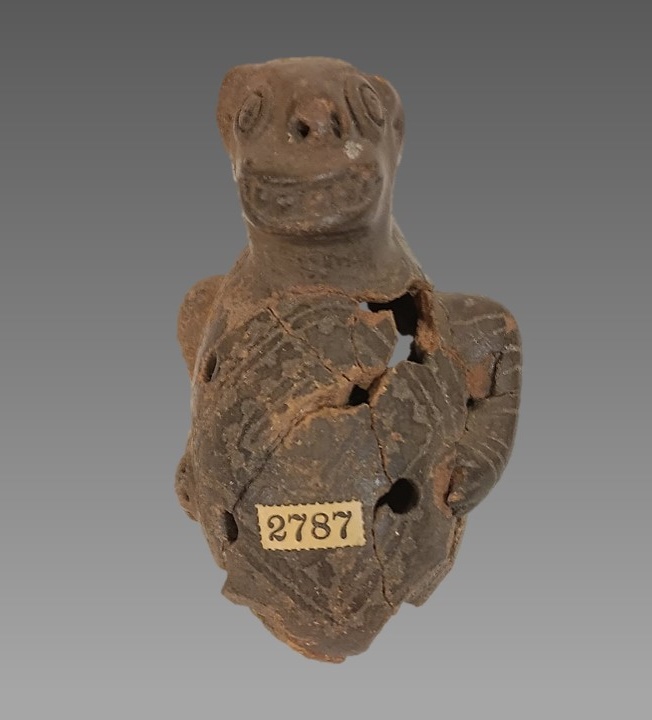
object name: pottery whistle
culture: costa rican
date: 800-1525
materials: pottery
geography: costa rica